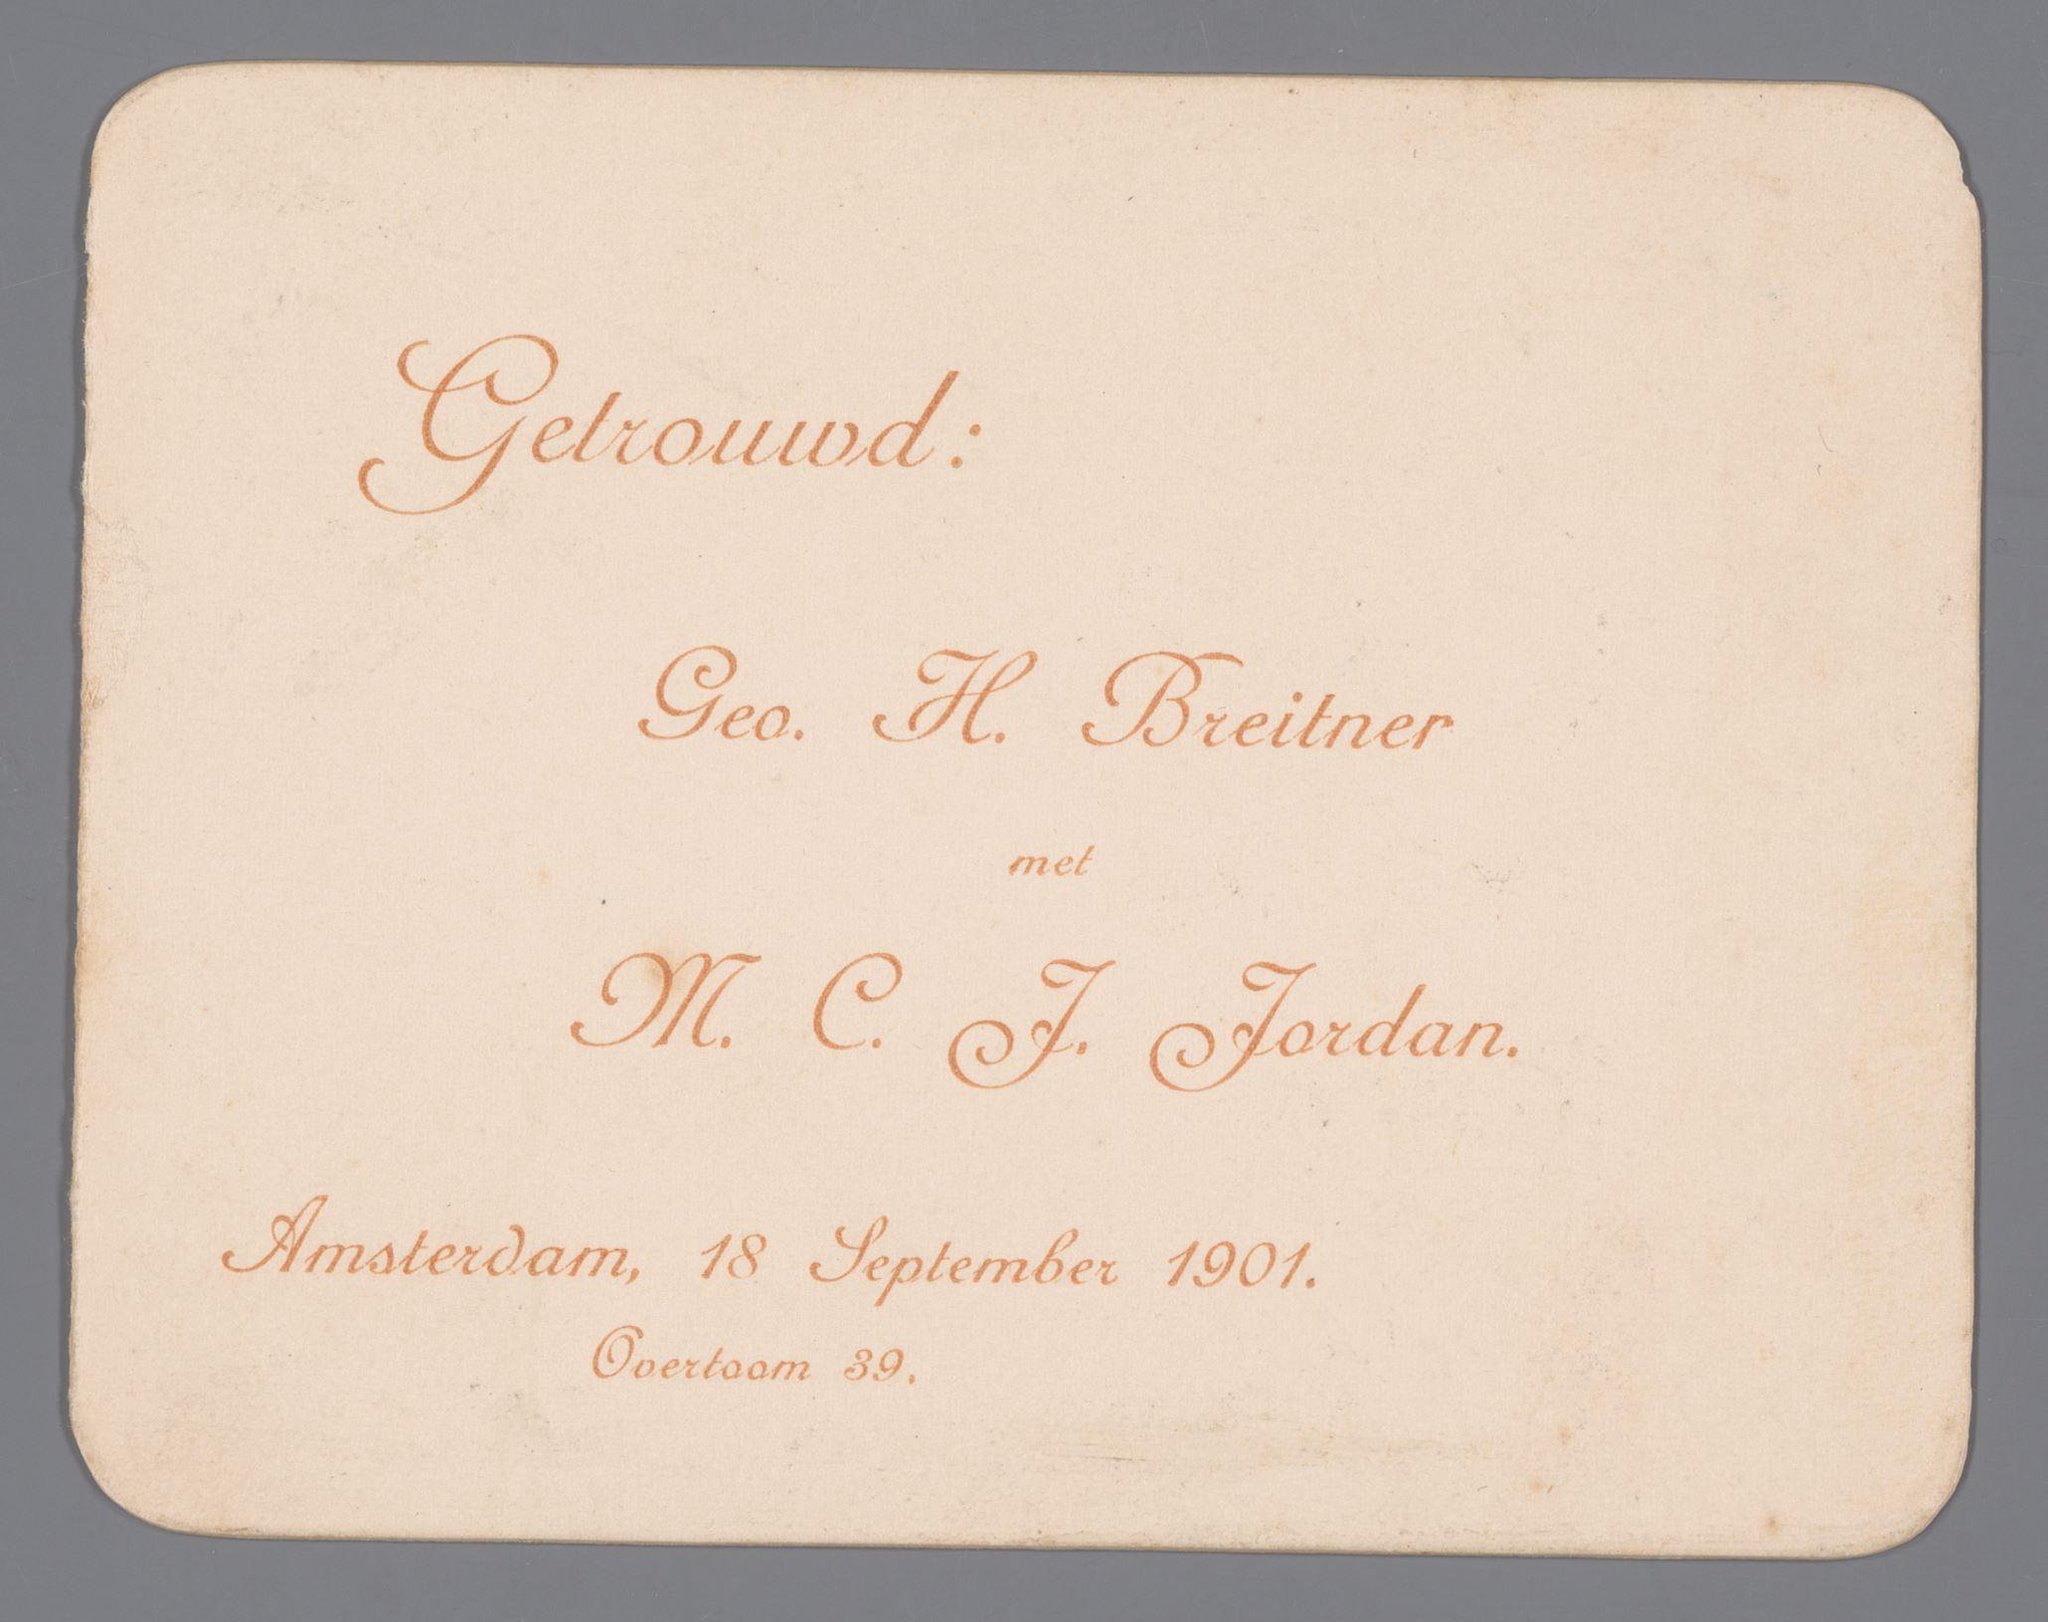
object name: document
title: Aankondiging van de bruiloft van George Hendrik Breitner en Marie Jordan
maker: Anonymous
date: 1901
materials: cardboard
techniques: printing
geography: netherlands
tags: rotterdam, print maker, draughtsman, george hendrik breitner, marie jordan